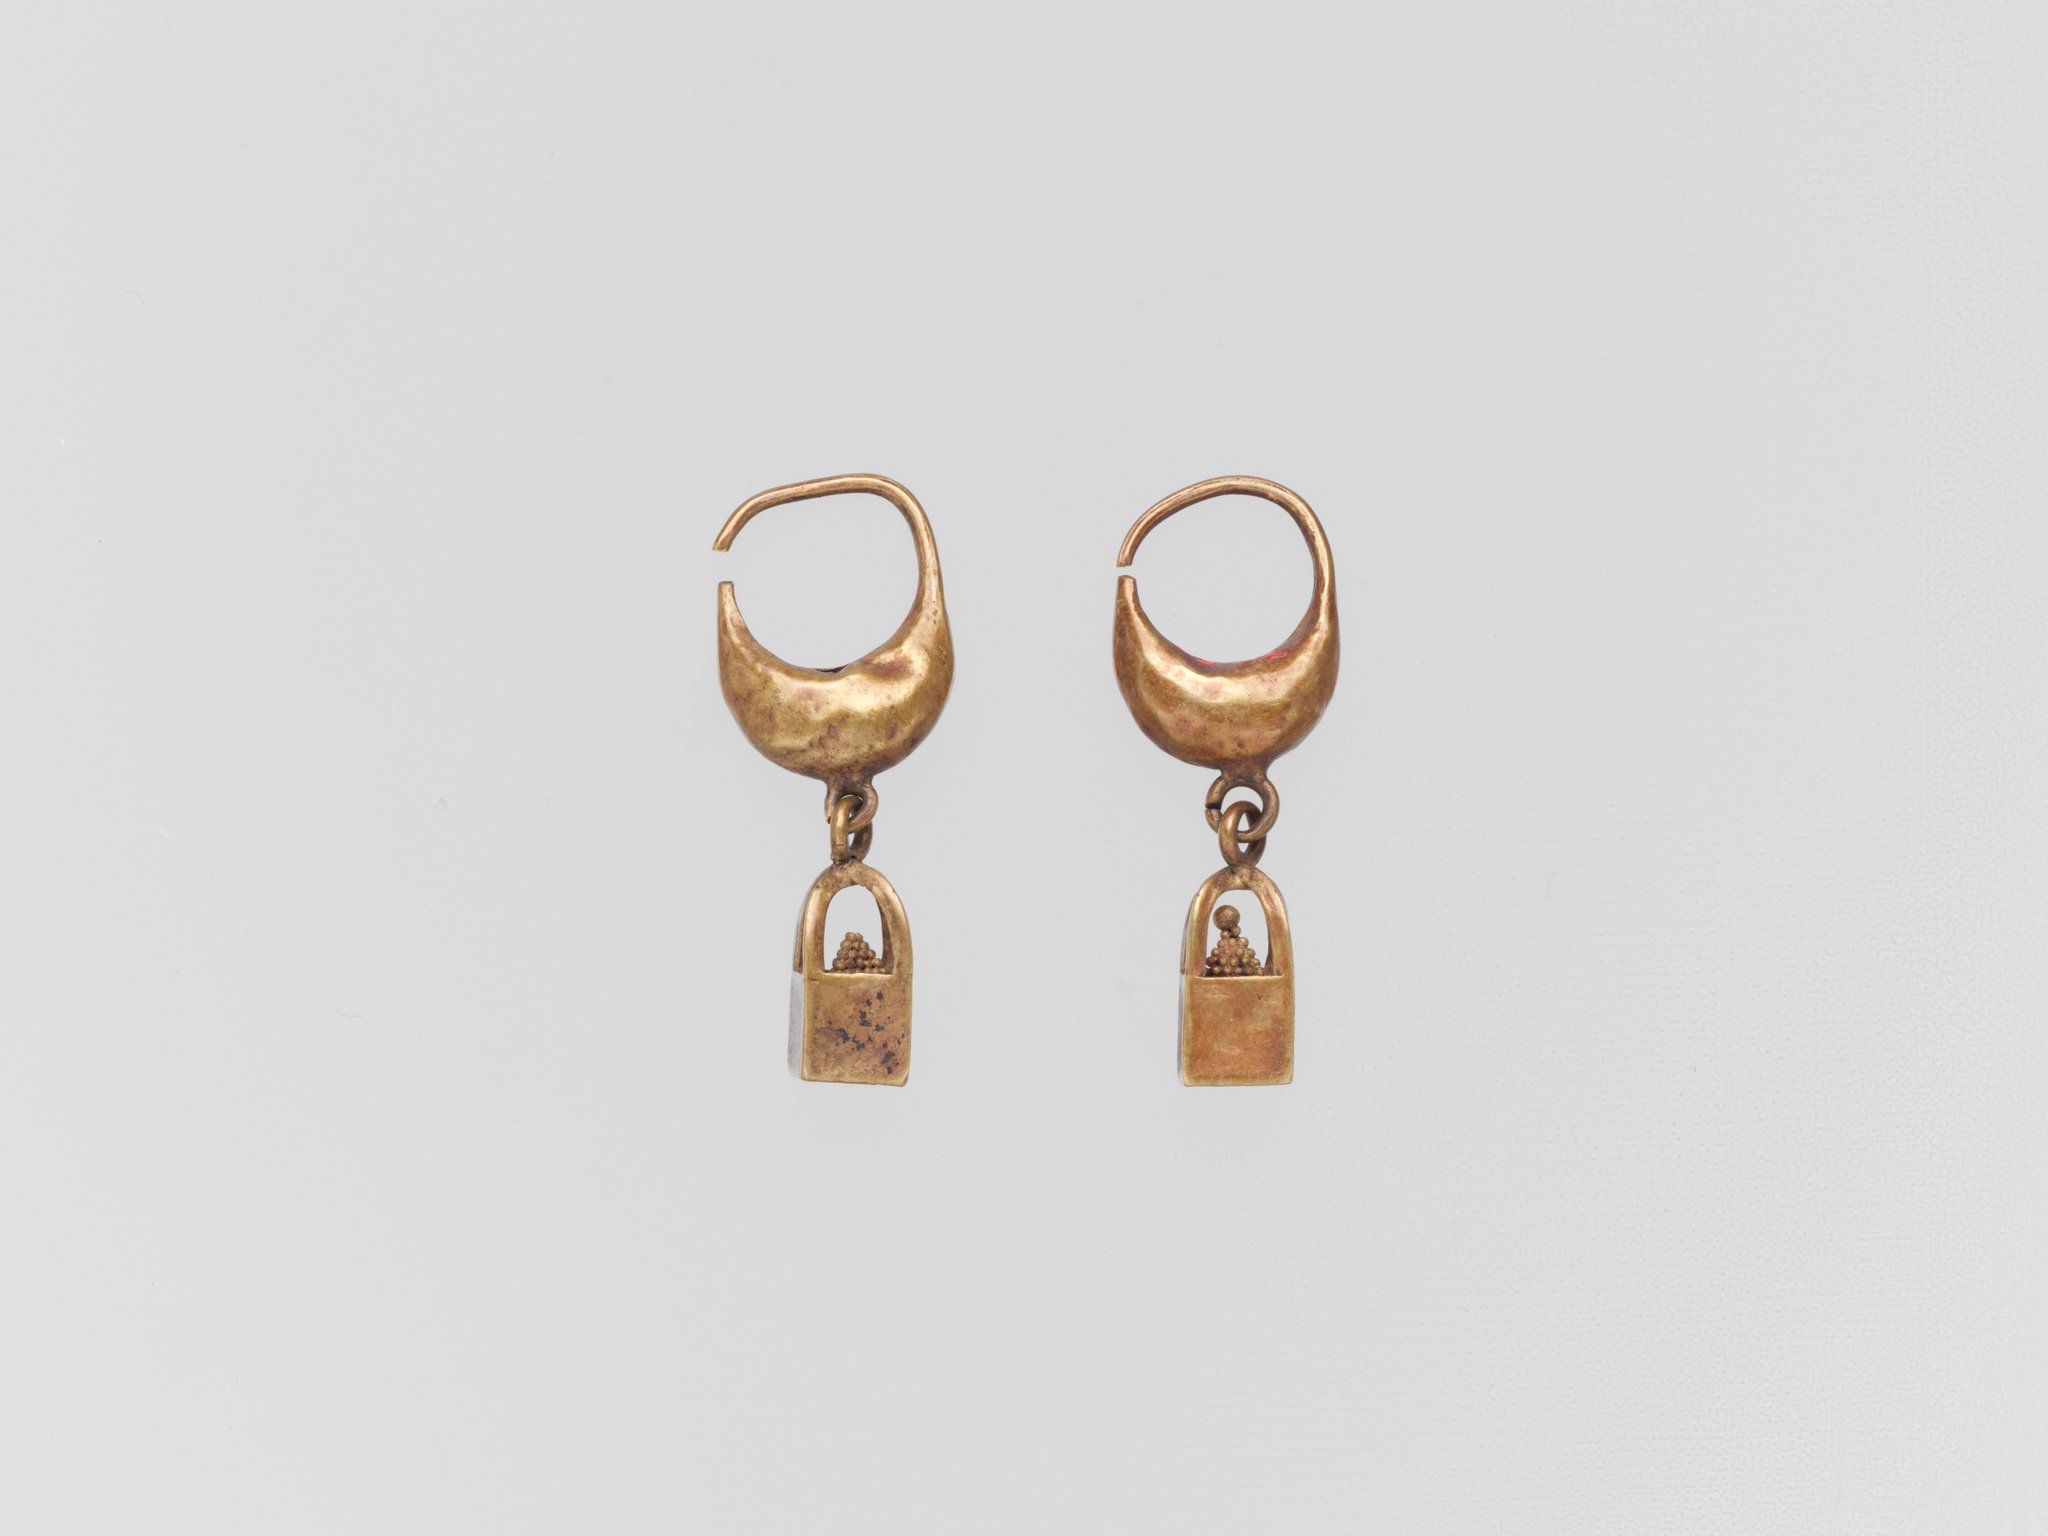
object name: earring, boat shaped with cage and ball pendant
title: Gold earring with cage and ball pendant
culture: cypriot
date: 700-501 BCE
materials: gold